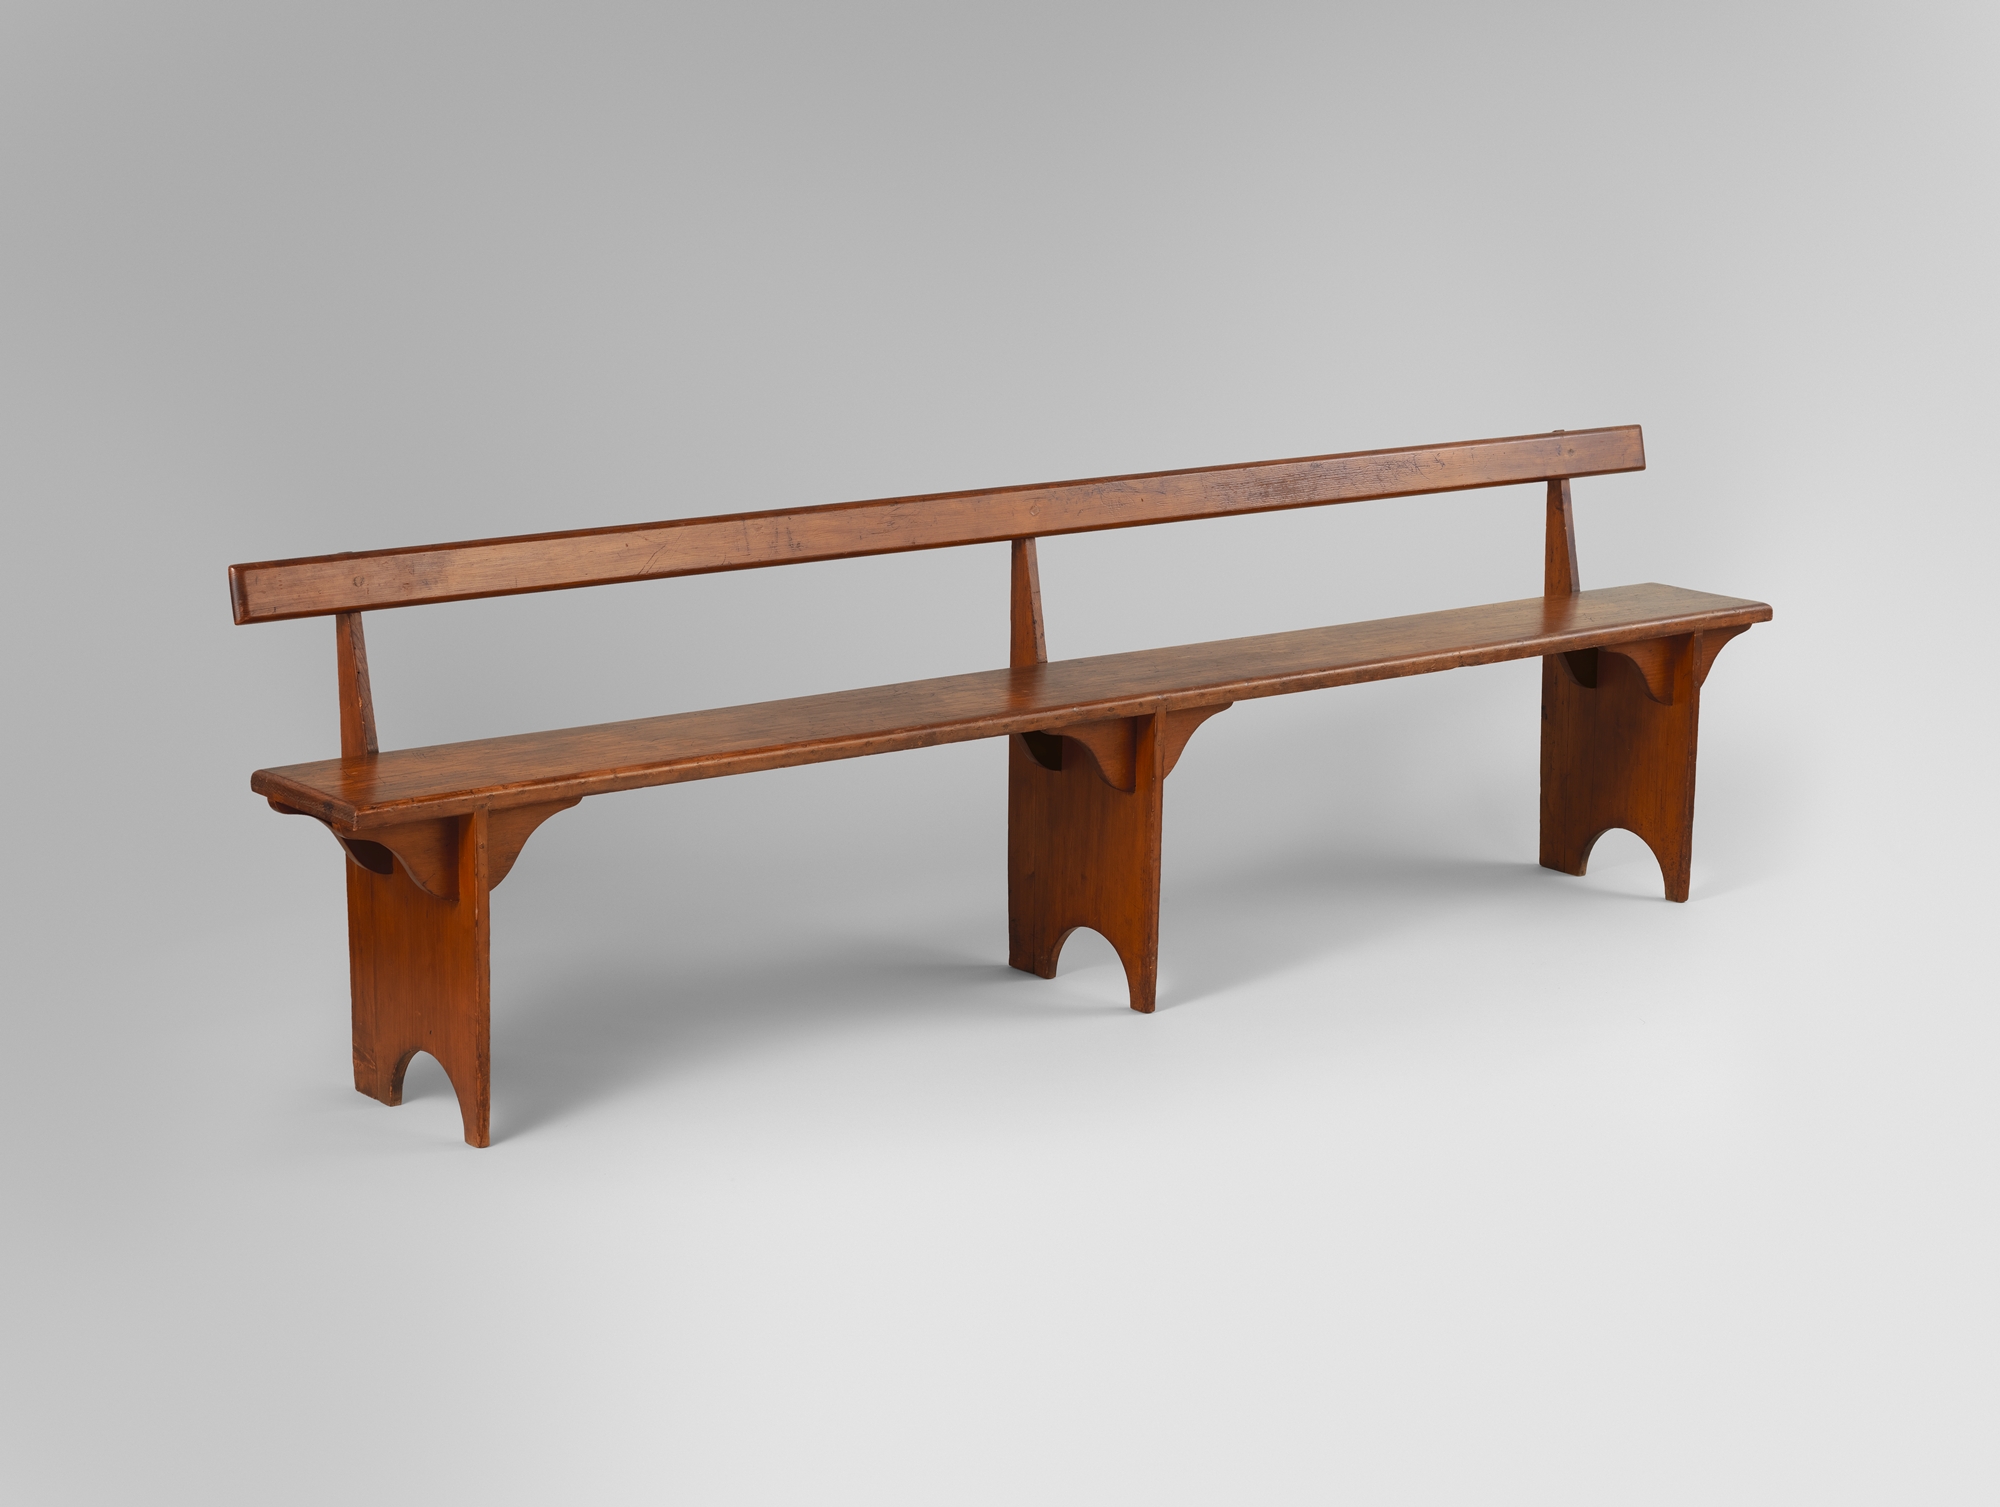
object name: bench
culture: american, shaker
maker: united society of believers in christ’s second appearing (“shakers”)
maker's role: maker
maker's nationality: american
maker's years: 1750-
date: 1825-1850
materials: wood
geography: united states